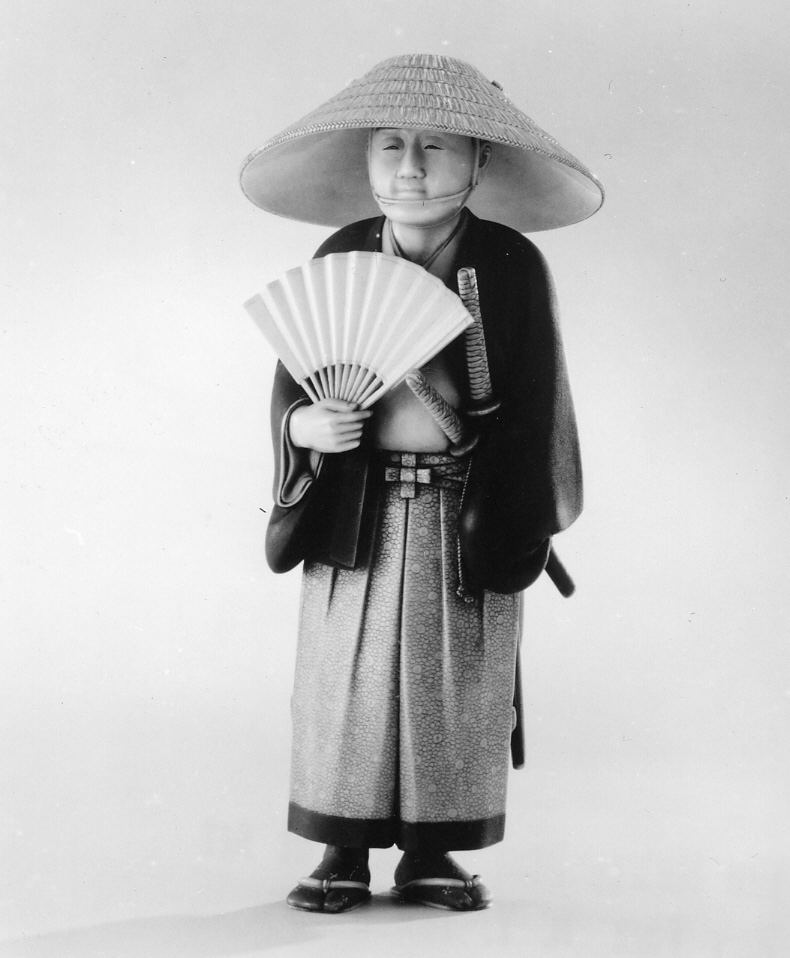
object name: statuette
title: Standing Man in Long Robes with Two Swords in His Sash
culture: japanese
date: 1901-2000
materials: ivory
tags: fans,hats,swords,men